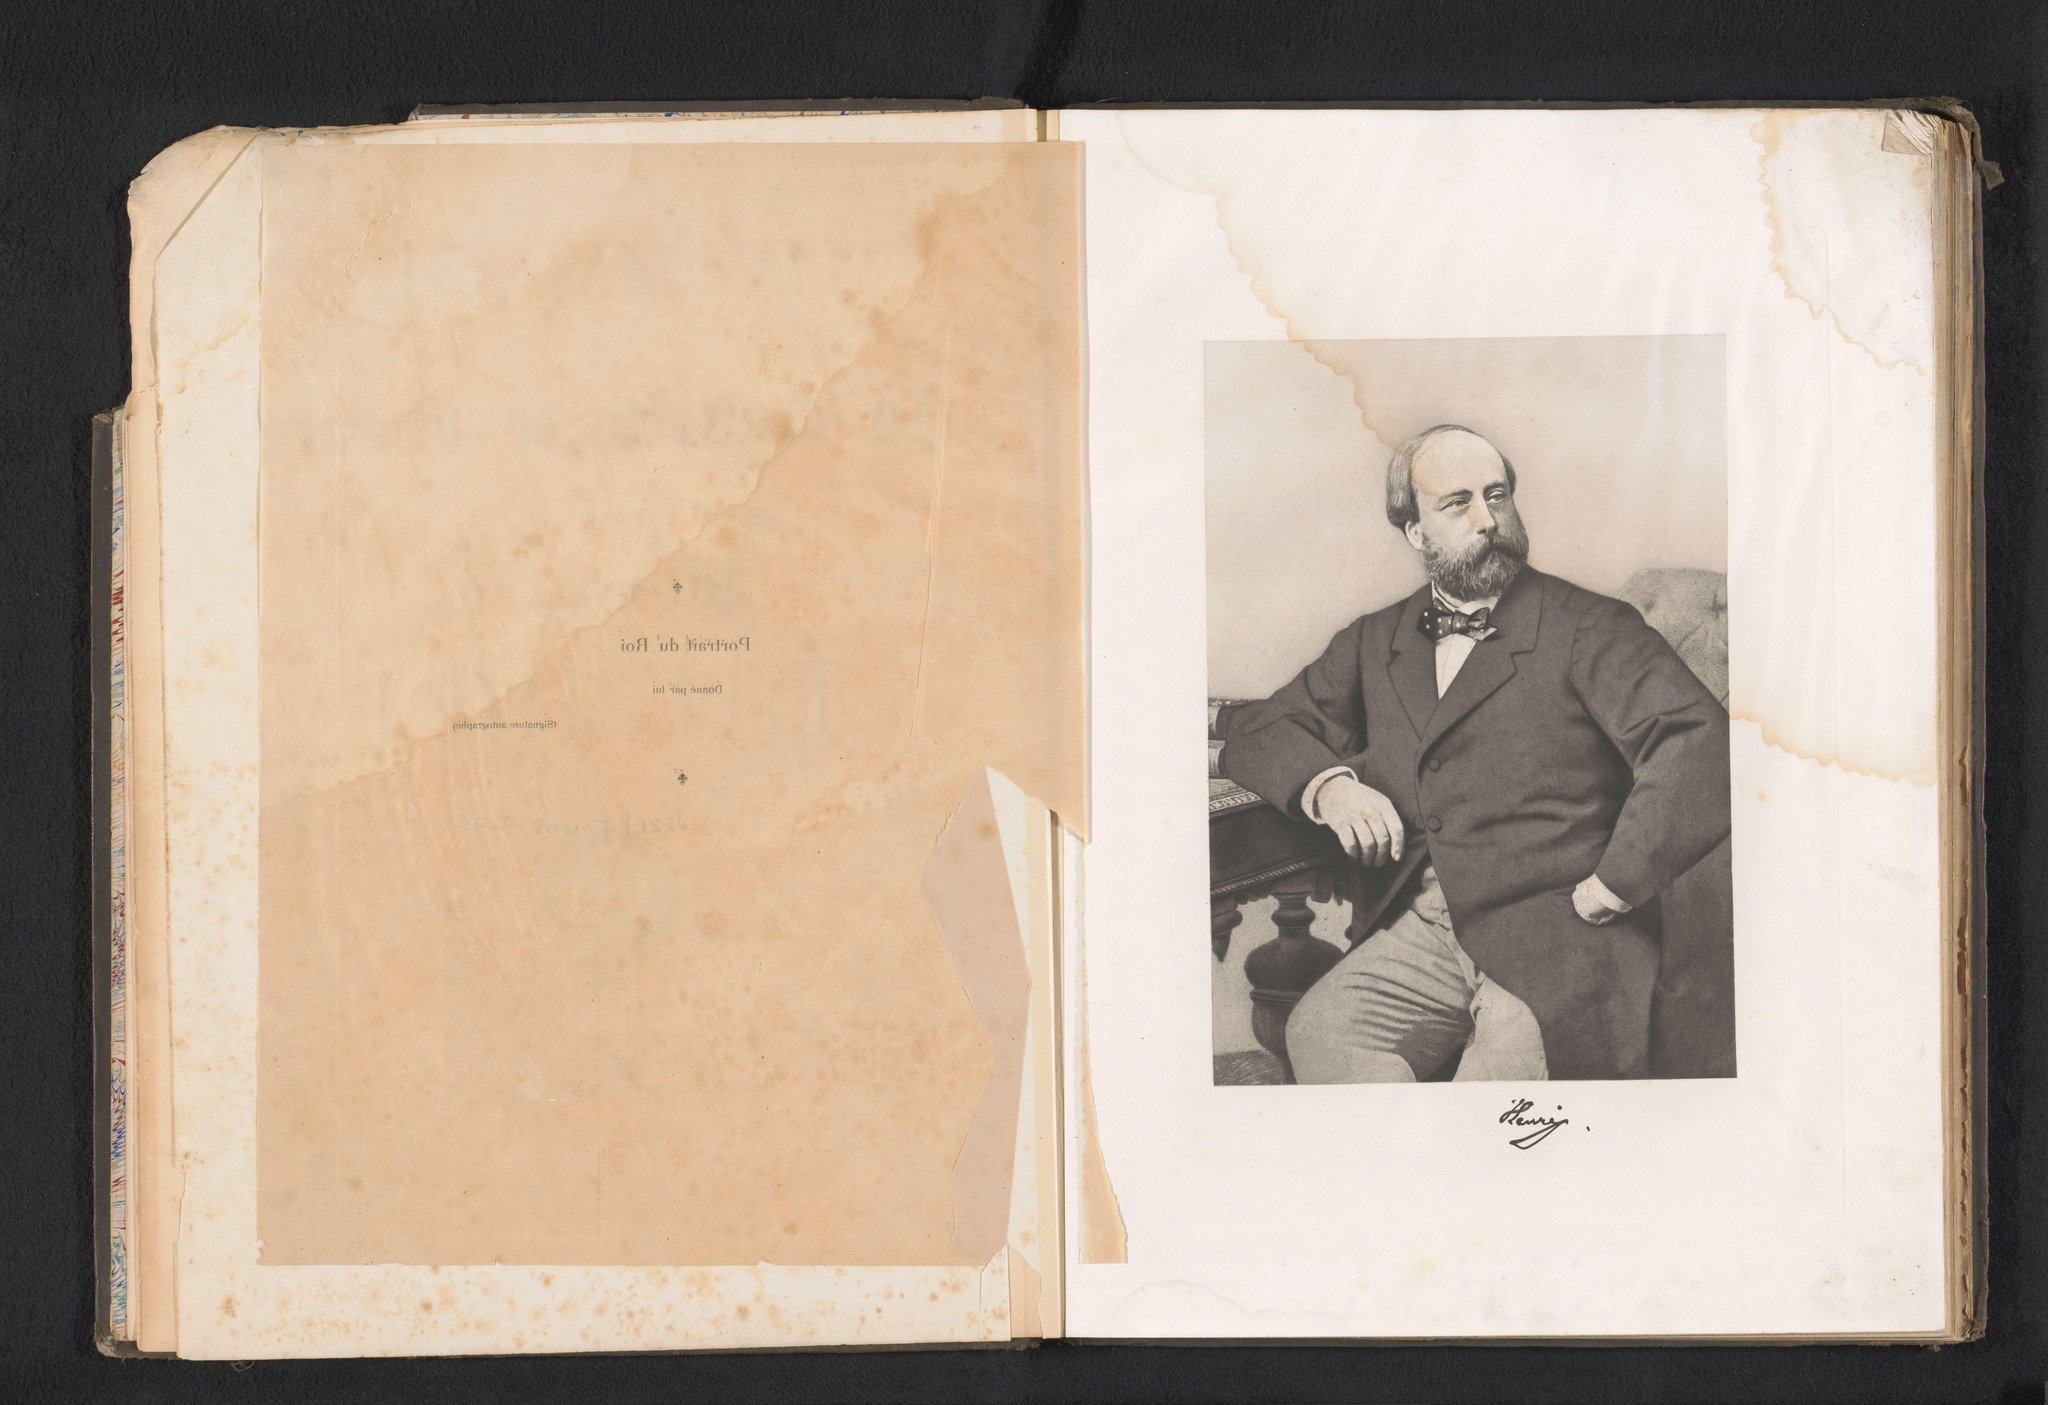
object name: photomechanical print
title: Portret van Henri d'Artois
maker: Anonymous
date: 1878-1883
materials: paper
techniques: photoaquatint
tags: tuileries palace, historical persons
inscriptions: signature: ‘Henri.’